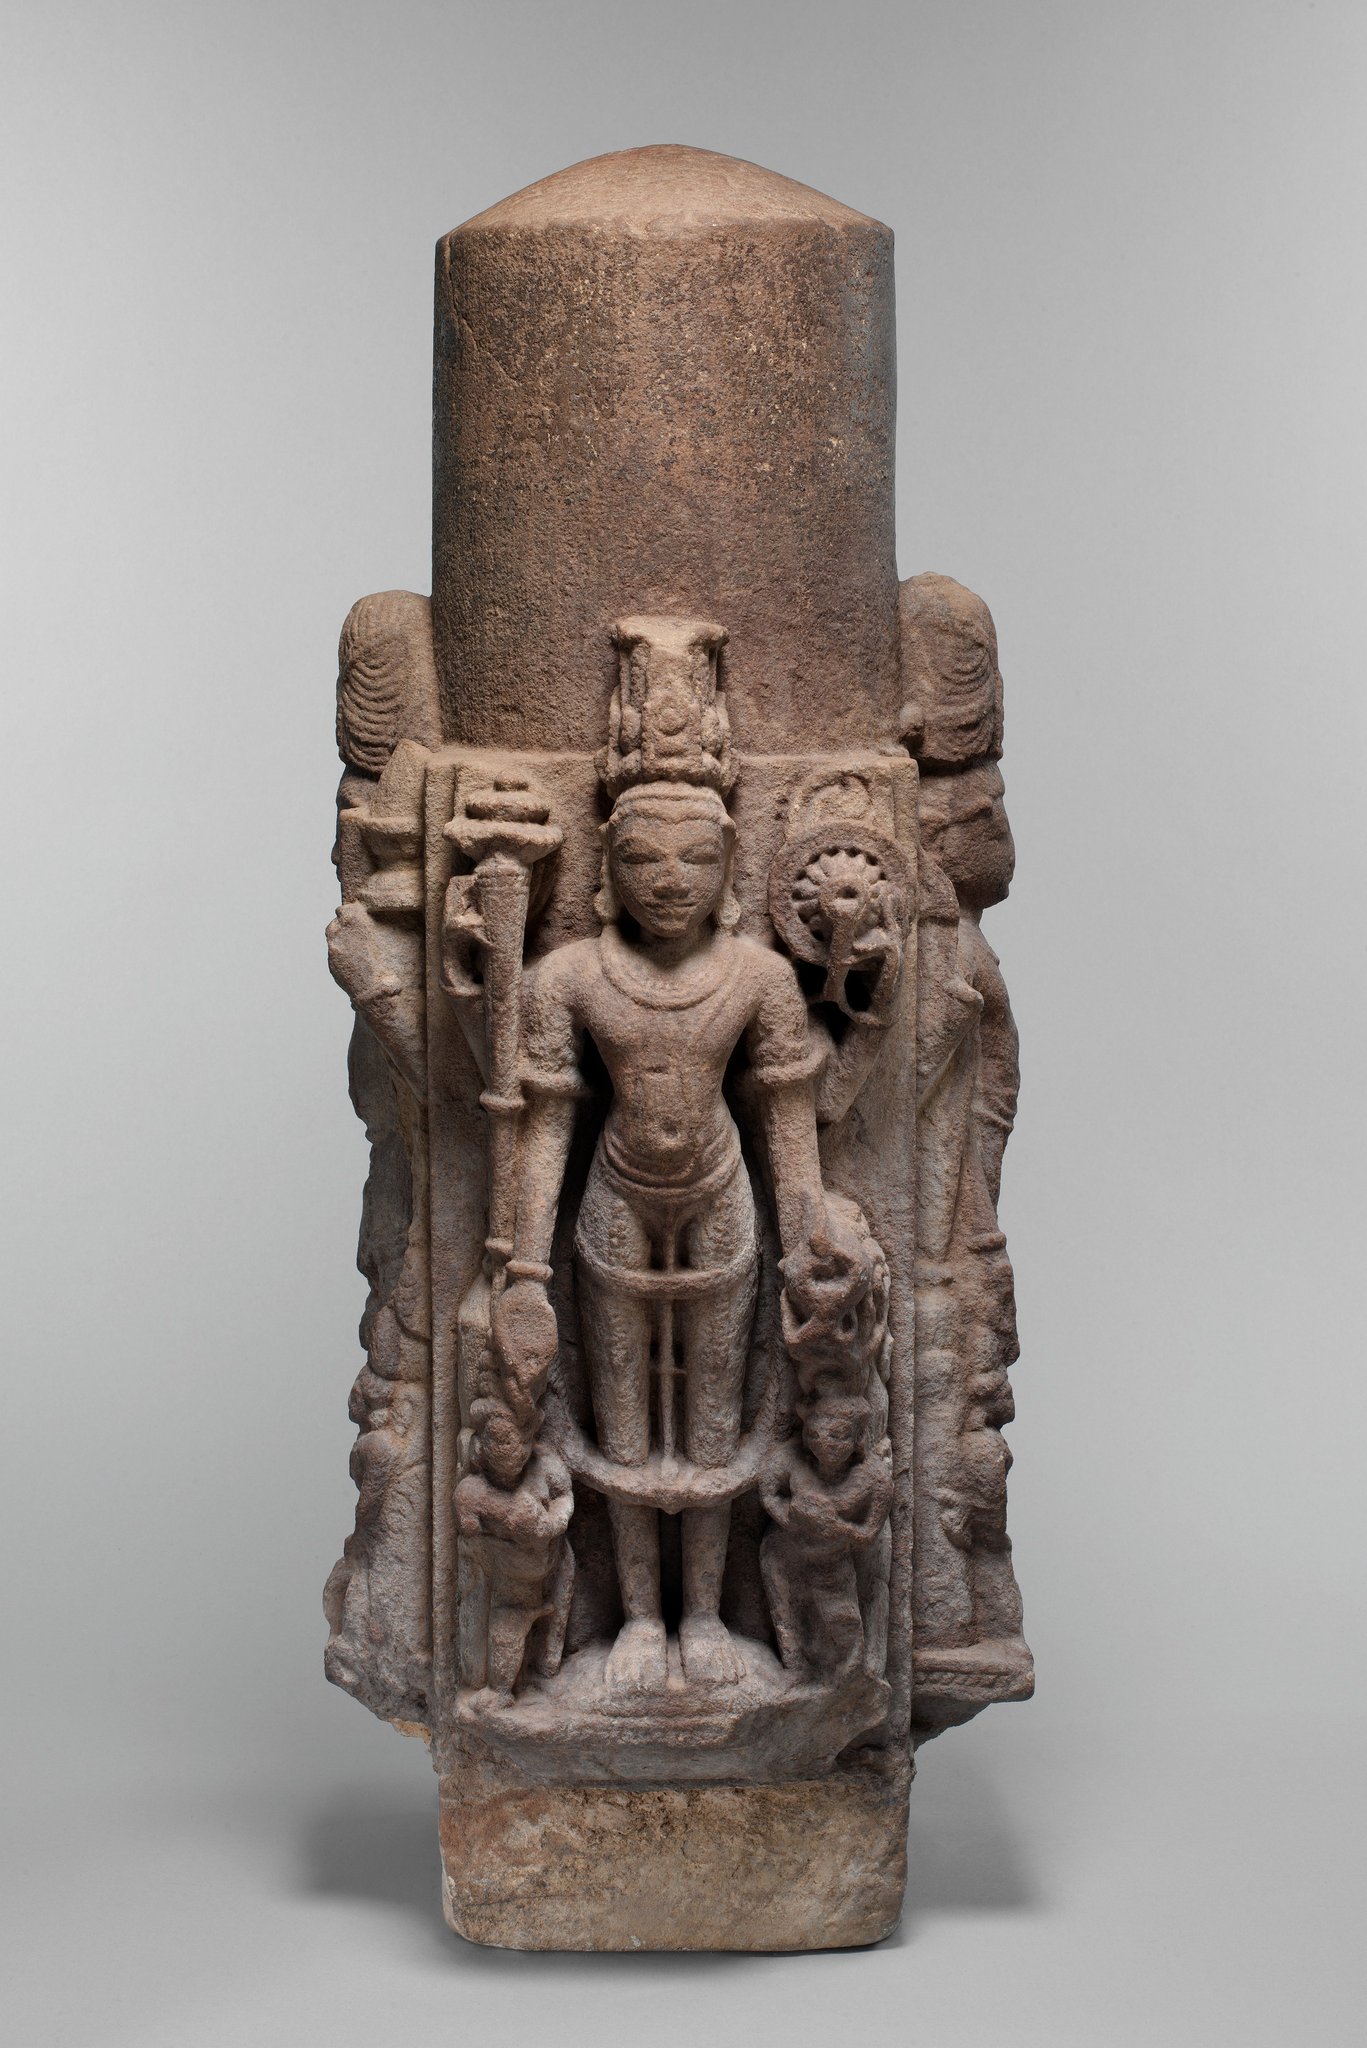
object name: sculpture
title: Linga (Phallic Emblem) with Four Standing Deities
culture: indian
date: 901-1100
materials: stone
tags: hinduism